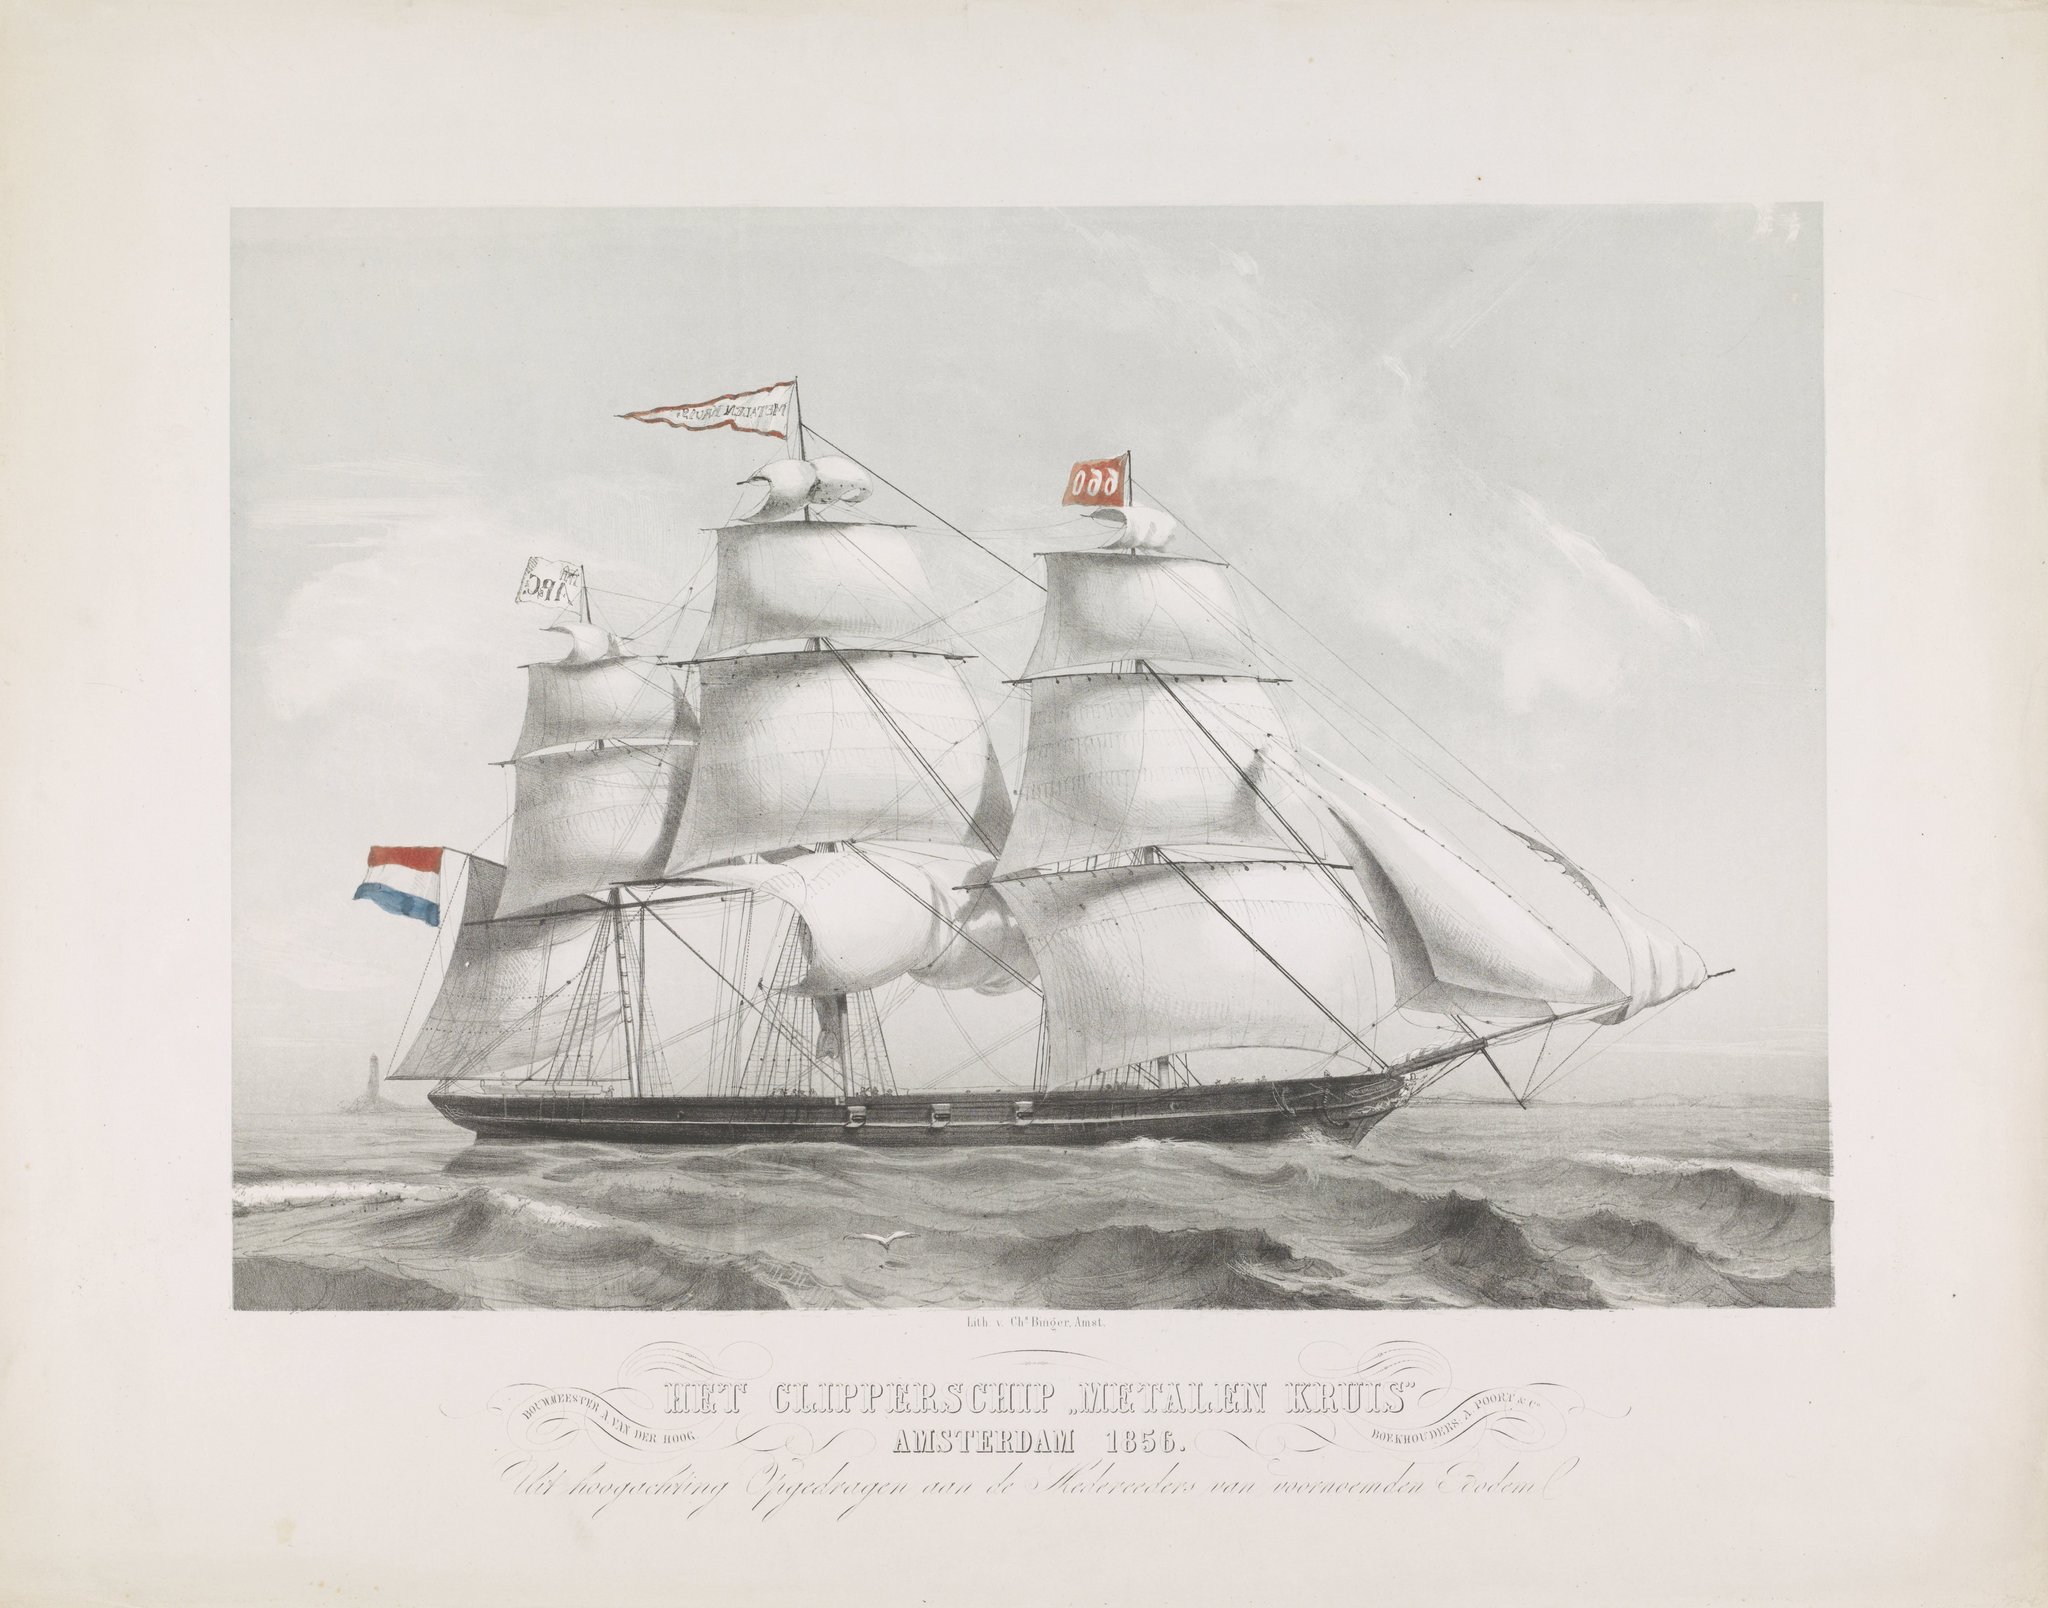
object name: print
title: Het Clipperschip "Metalen Kruis" Amsterdam 1856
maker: charles binger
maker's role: print maker, printer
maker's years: 1830-1916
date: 1856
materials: paper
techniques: hand coloring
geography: amsterdam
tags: ship's portrait (+ propulsion of vehicle, ship, etc. by wind), amsterdam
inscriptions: collector's mark: Lugt 2228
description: De klipper genaamd 'Metalen Kruis', gebouwd te Amsterdam door A. van der Hoog voor de boekhouders A. Poort & Co. en van stapel gelaten in september als onderdeel van de feestelijkheden rond de onthulling van het monument Gedenkteken aan de Volksgeest van 1830 en 1831 te Amsterdam op 27 augustus 1856.